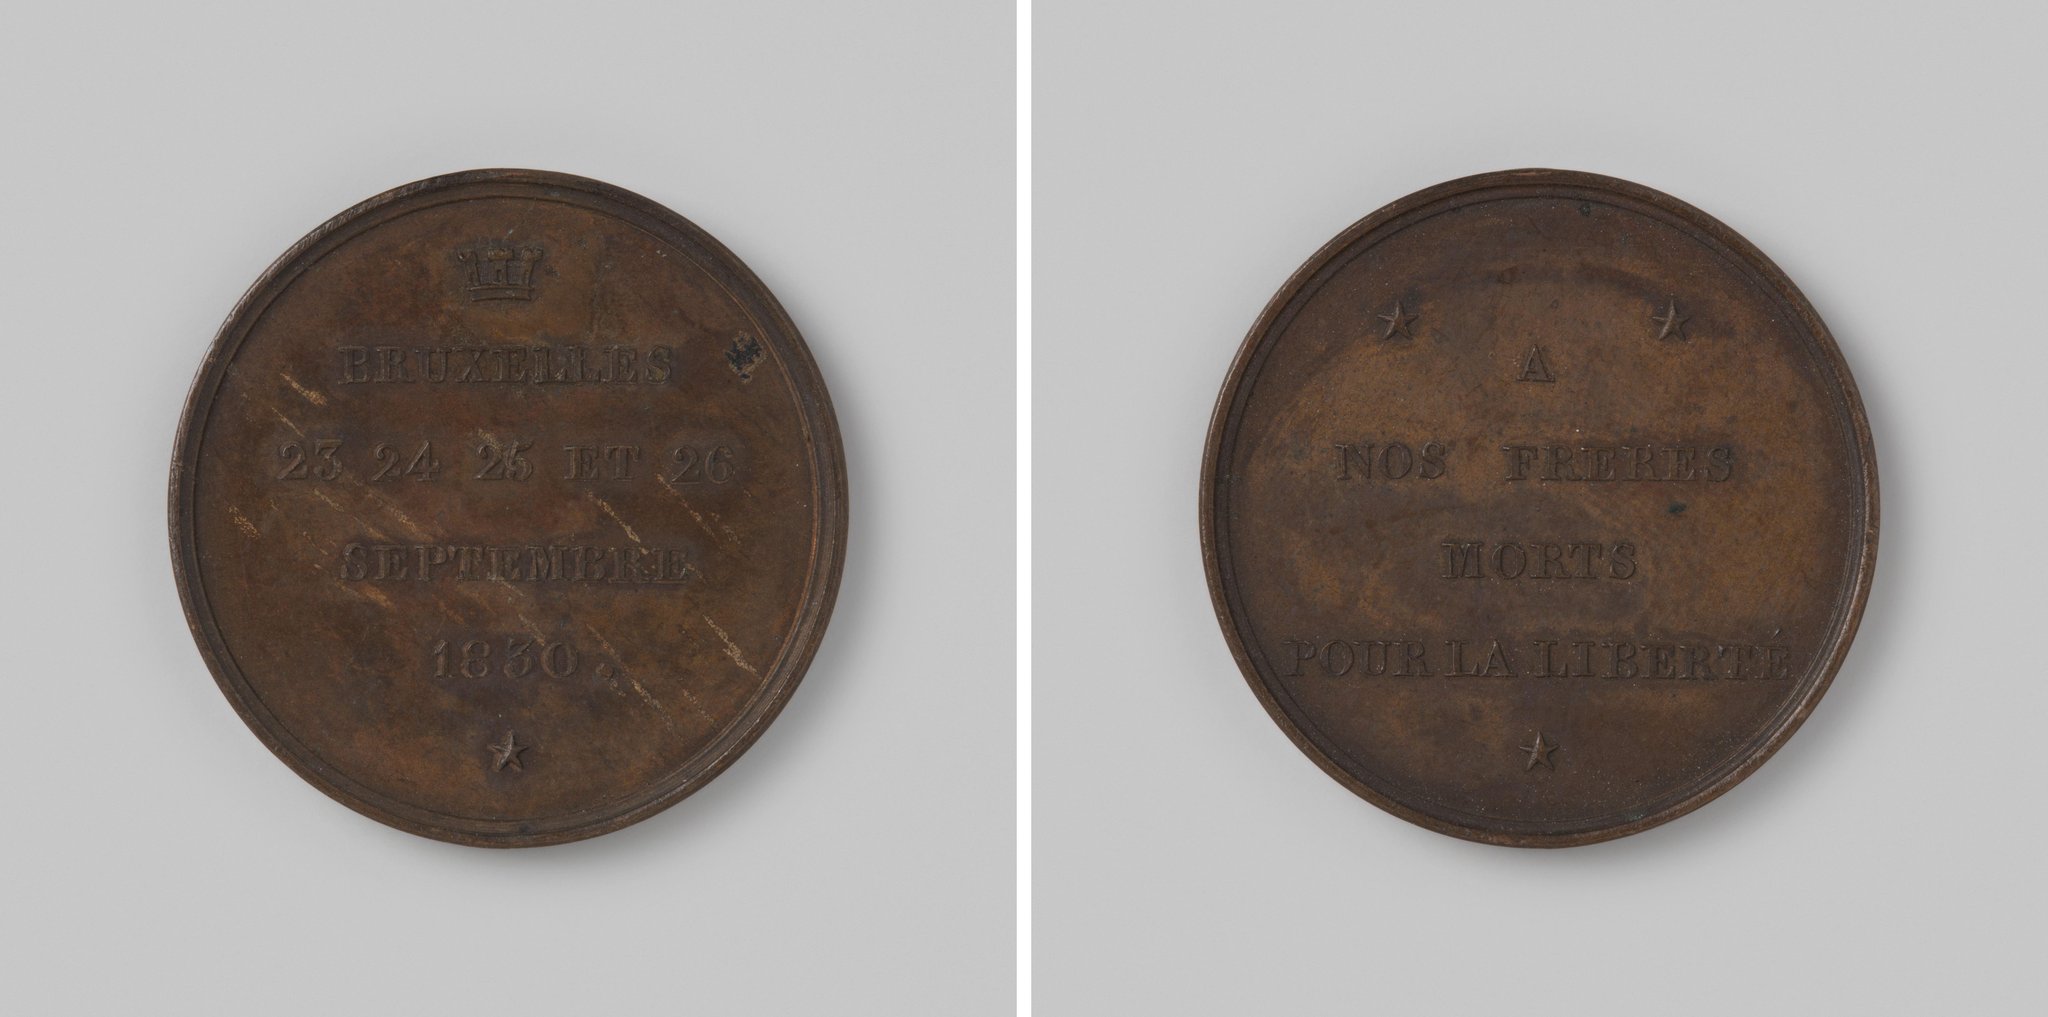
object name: history medal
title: Ter ere van de gesneuvelden te Brussel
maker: adrien hippolyte veyrat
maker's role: medailleur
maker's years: 1803-1883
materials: bronze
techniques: striking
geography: brussels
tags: brussels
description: Bronzen penning. Voorzijde: opschrift onder kroon. Keerzijde: opschrift en drie sterren